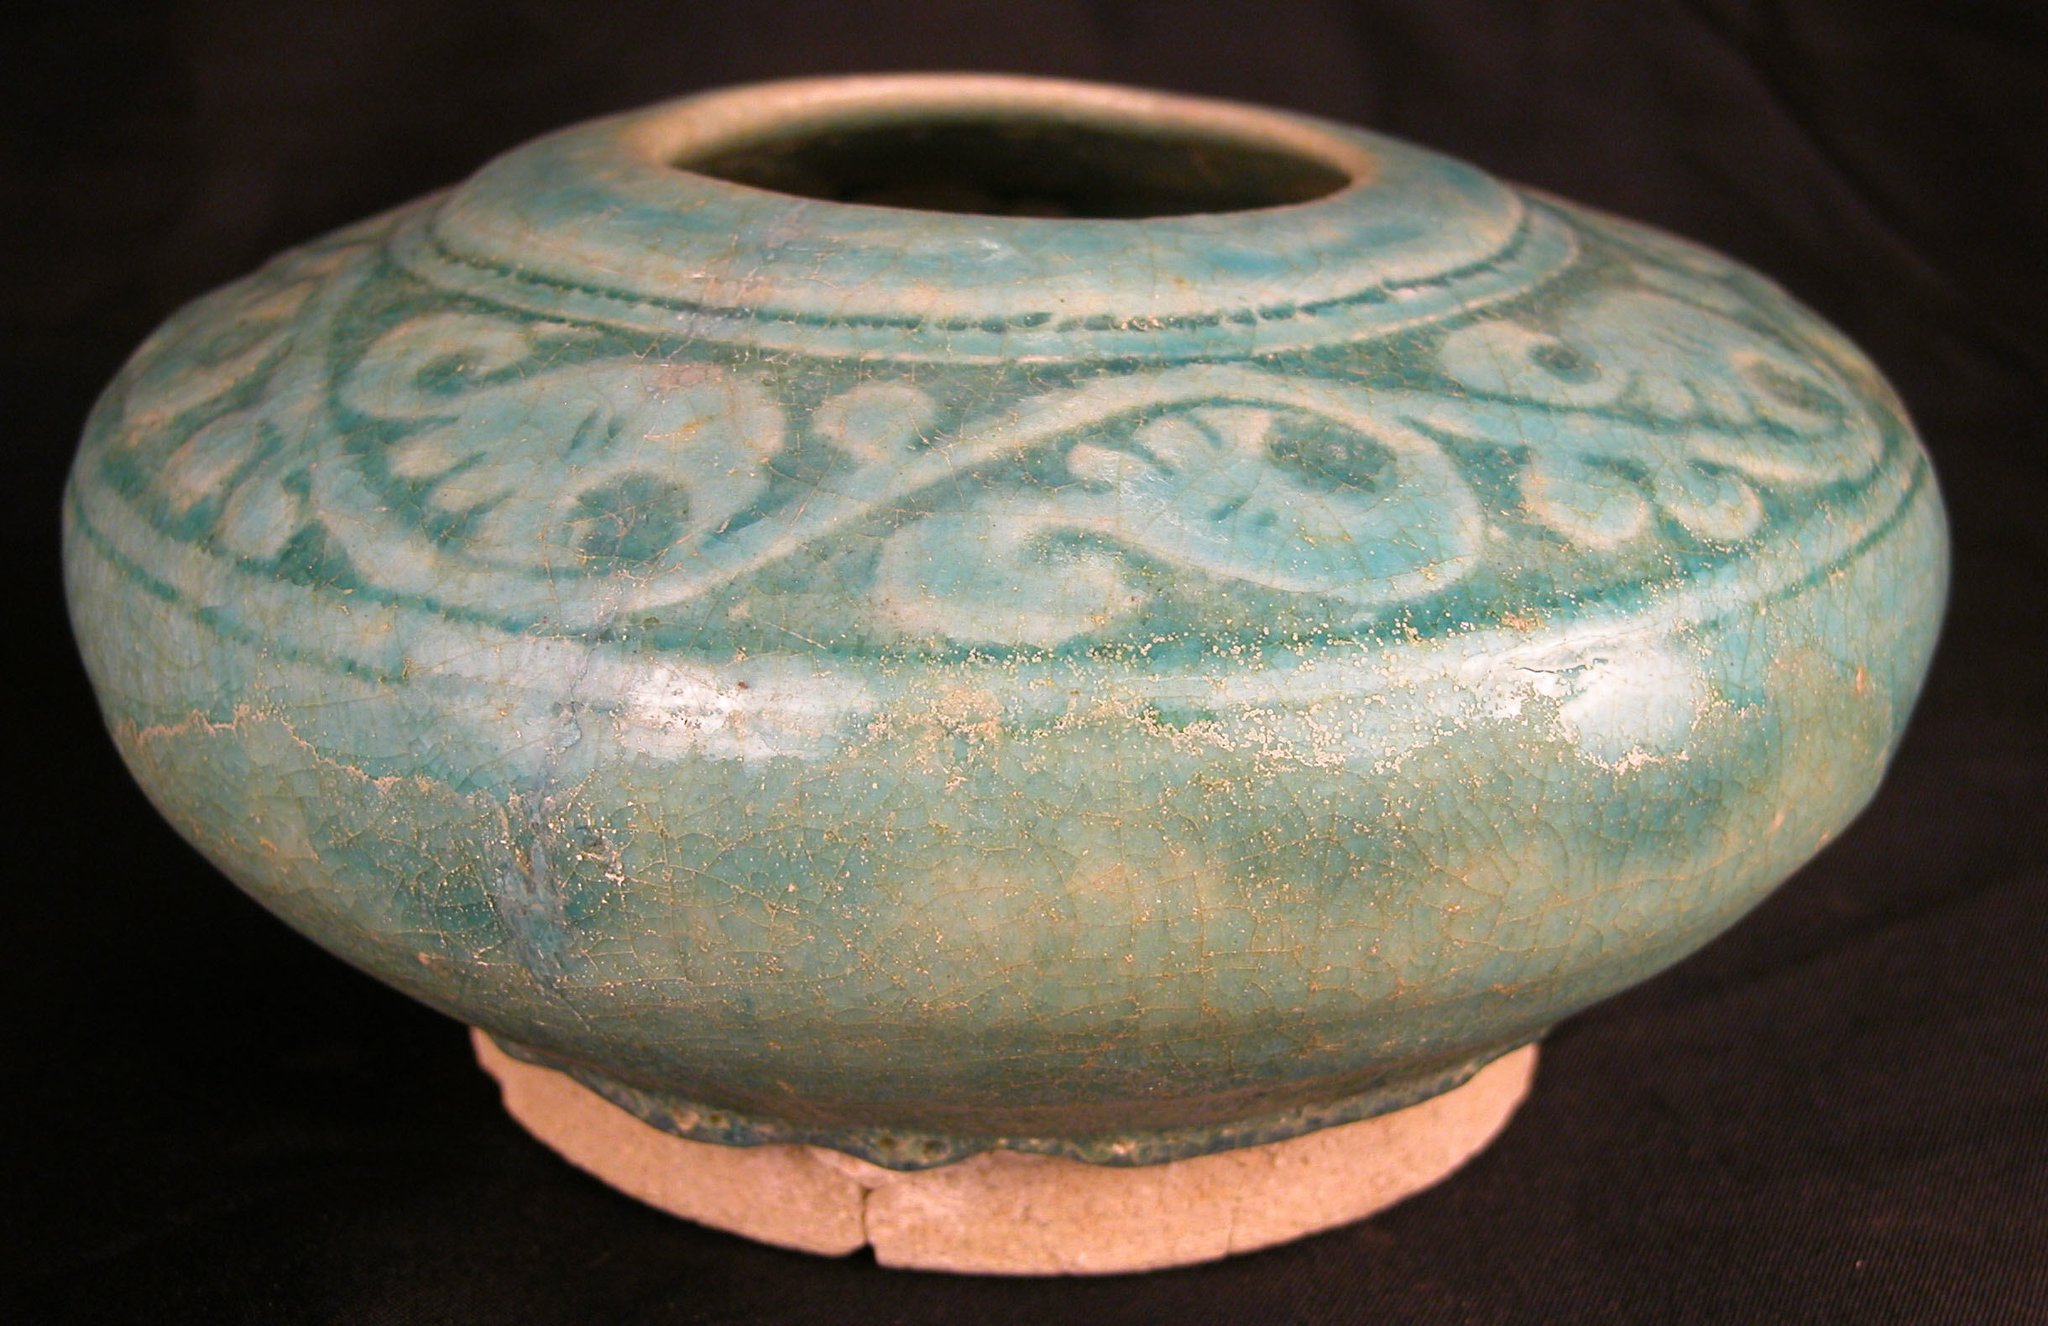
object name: jar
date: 1101-1200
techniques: carving, glazing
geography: egypt